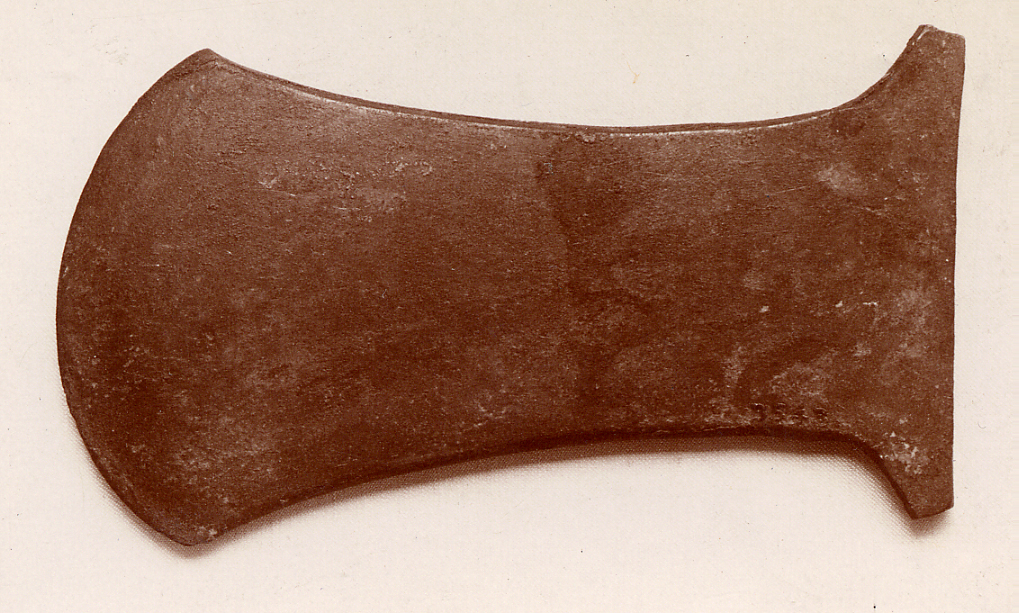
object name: ax head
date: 2030-1550 BCE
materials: bronze, copper alloy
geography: egypt